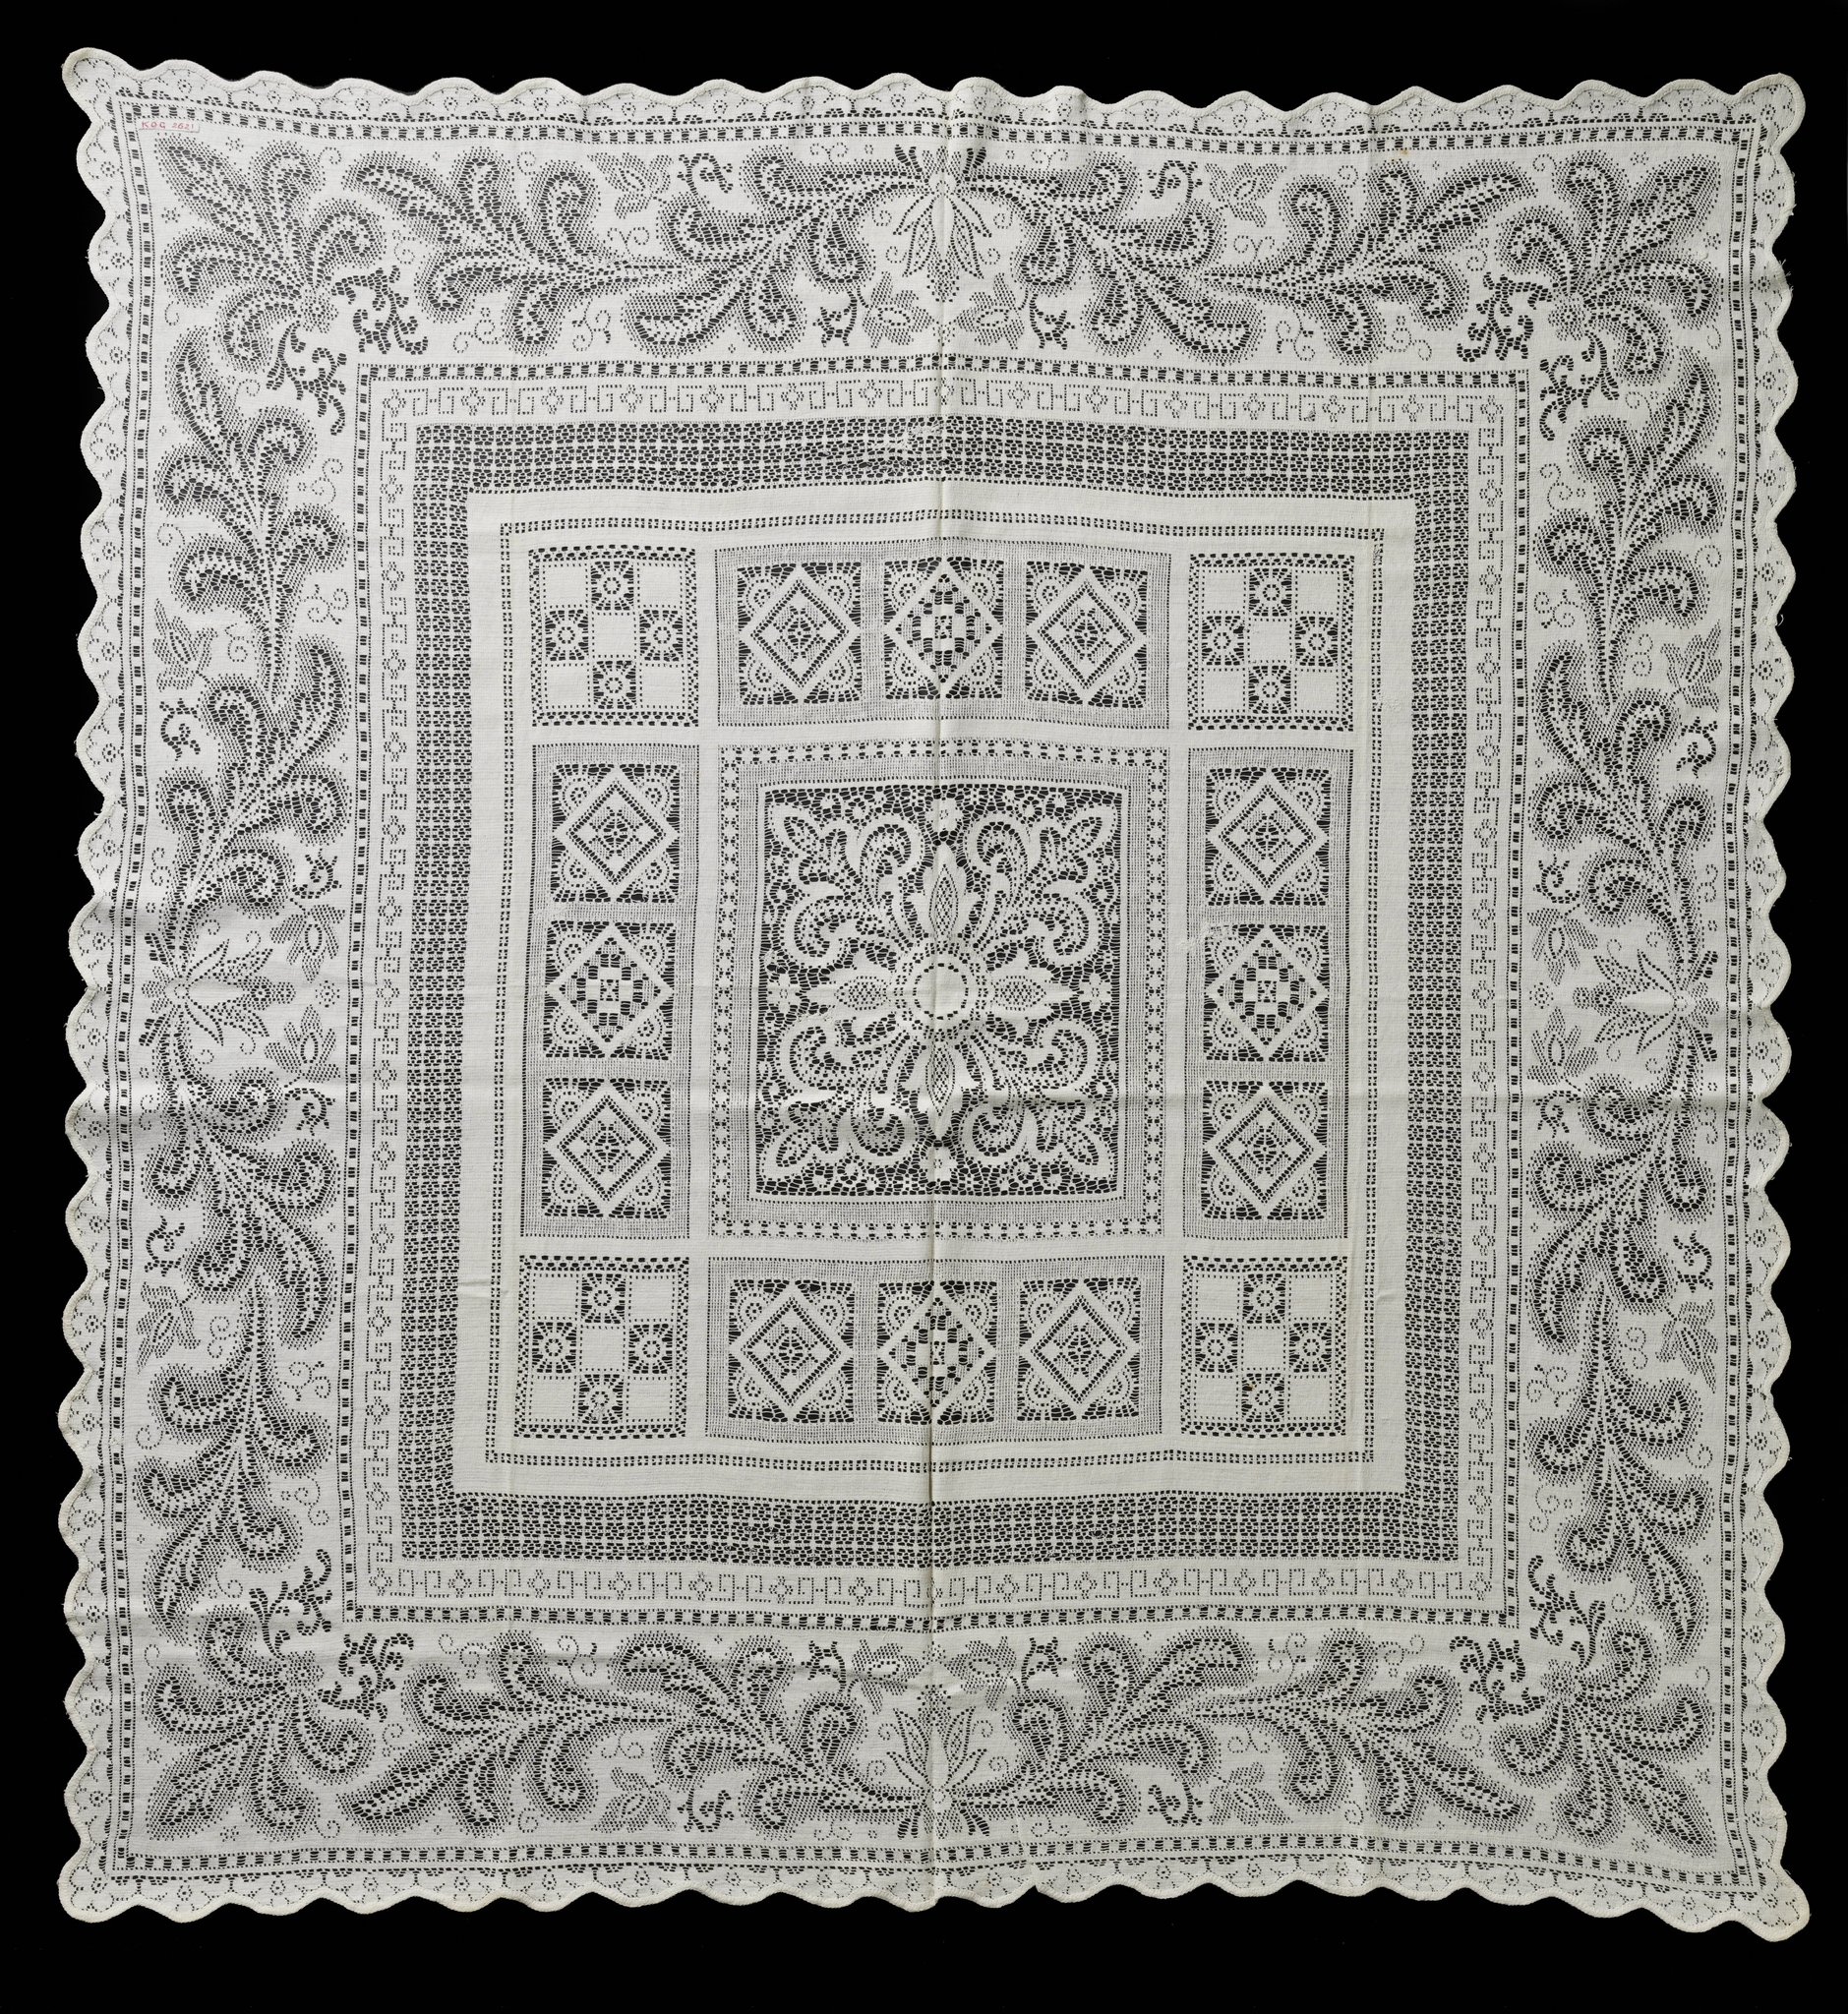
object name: doopkleed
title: Katoenen doopkleed van machinale kant met geometrisch patroon en acanthusbladeren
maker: Anonymous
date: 1850-1899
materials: cotton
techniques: lace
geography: netherlands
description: Katoenen doopkleed van naturelkleurige machinale kant. Vierkant model, met in het midden een geometrisch patroon van vierkanten en ruiten. Rond het middenveld loopt een brede rand met accolades van gerekte acanthusbladeren. Het kleed is afgewerkt met een regelmatig golvende schulpenrand, met steeds één half rozetbloempjes met twee blaadjes in een schulp.